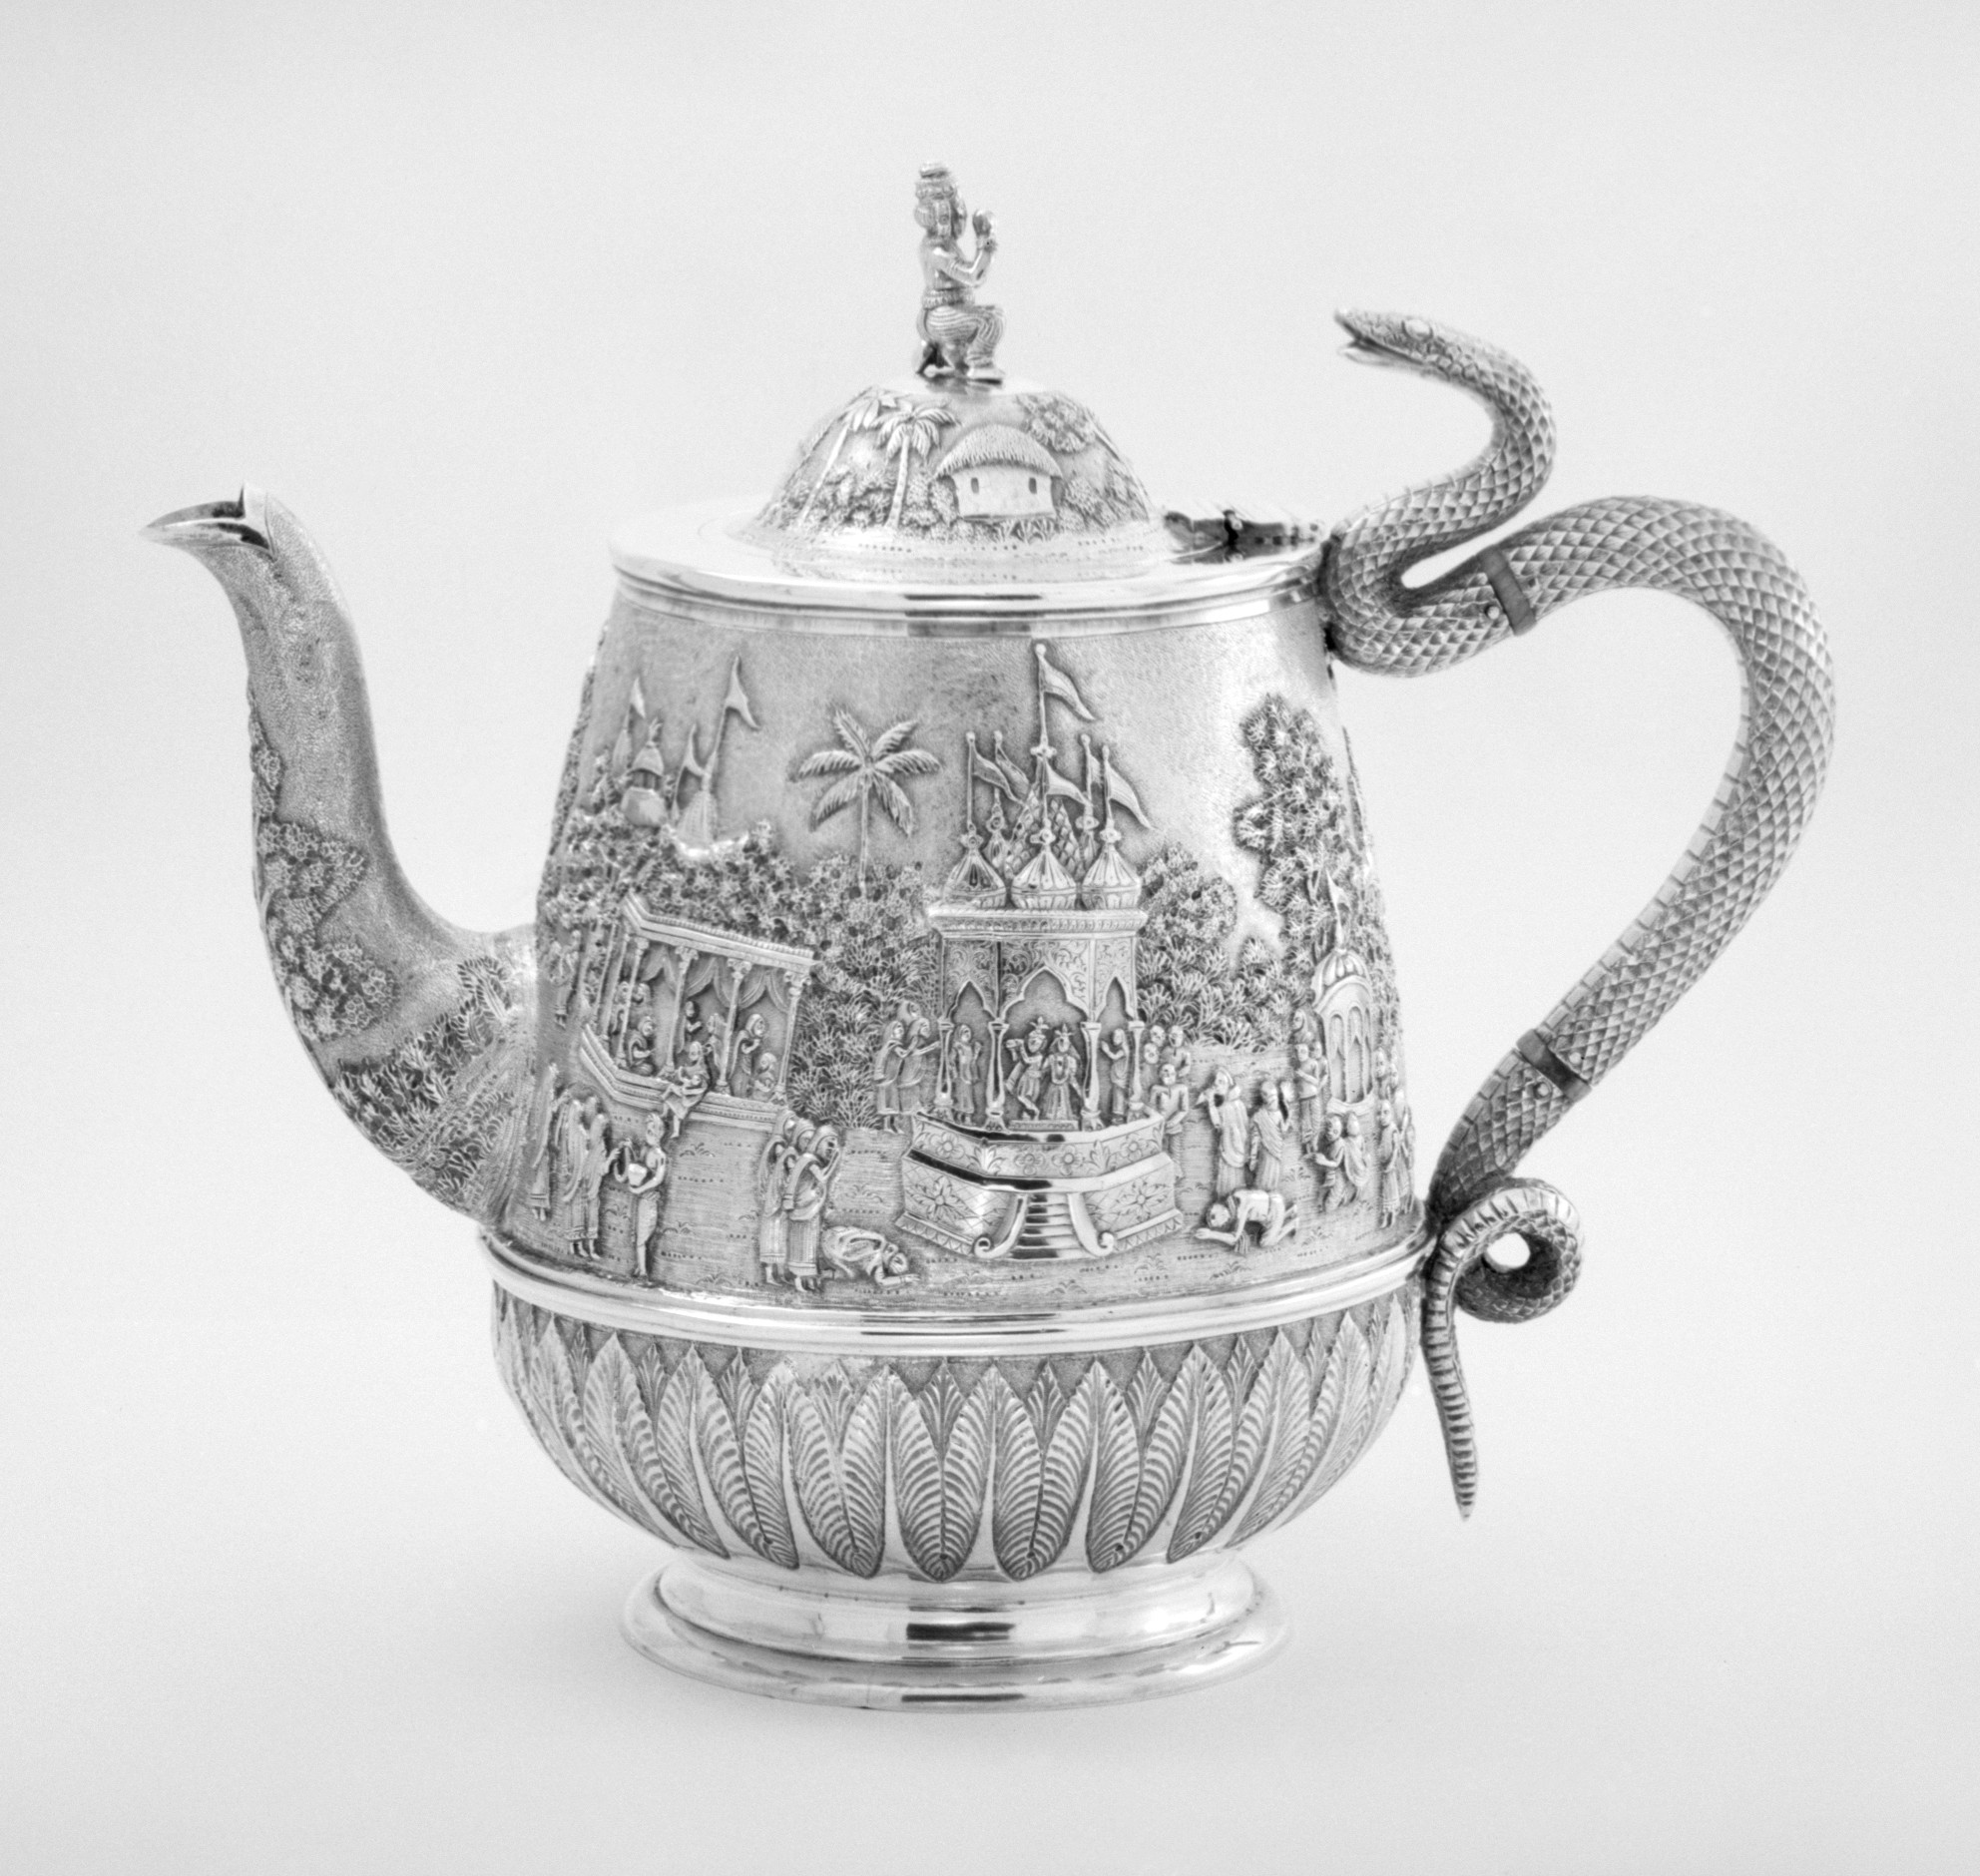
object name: teapot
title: Teapot (part of a set)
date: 1860-1880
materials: silver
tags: human figures,snakes